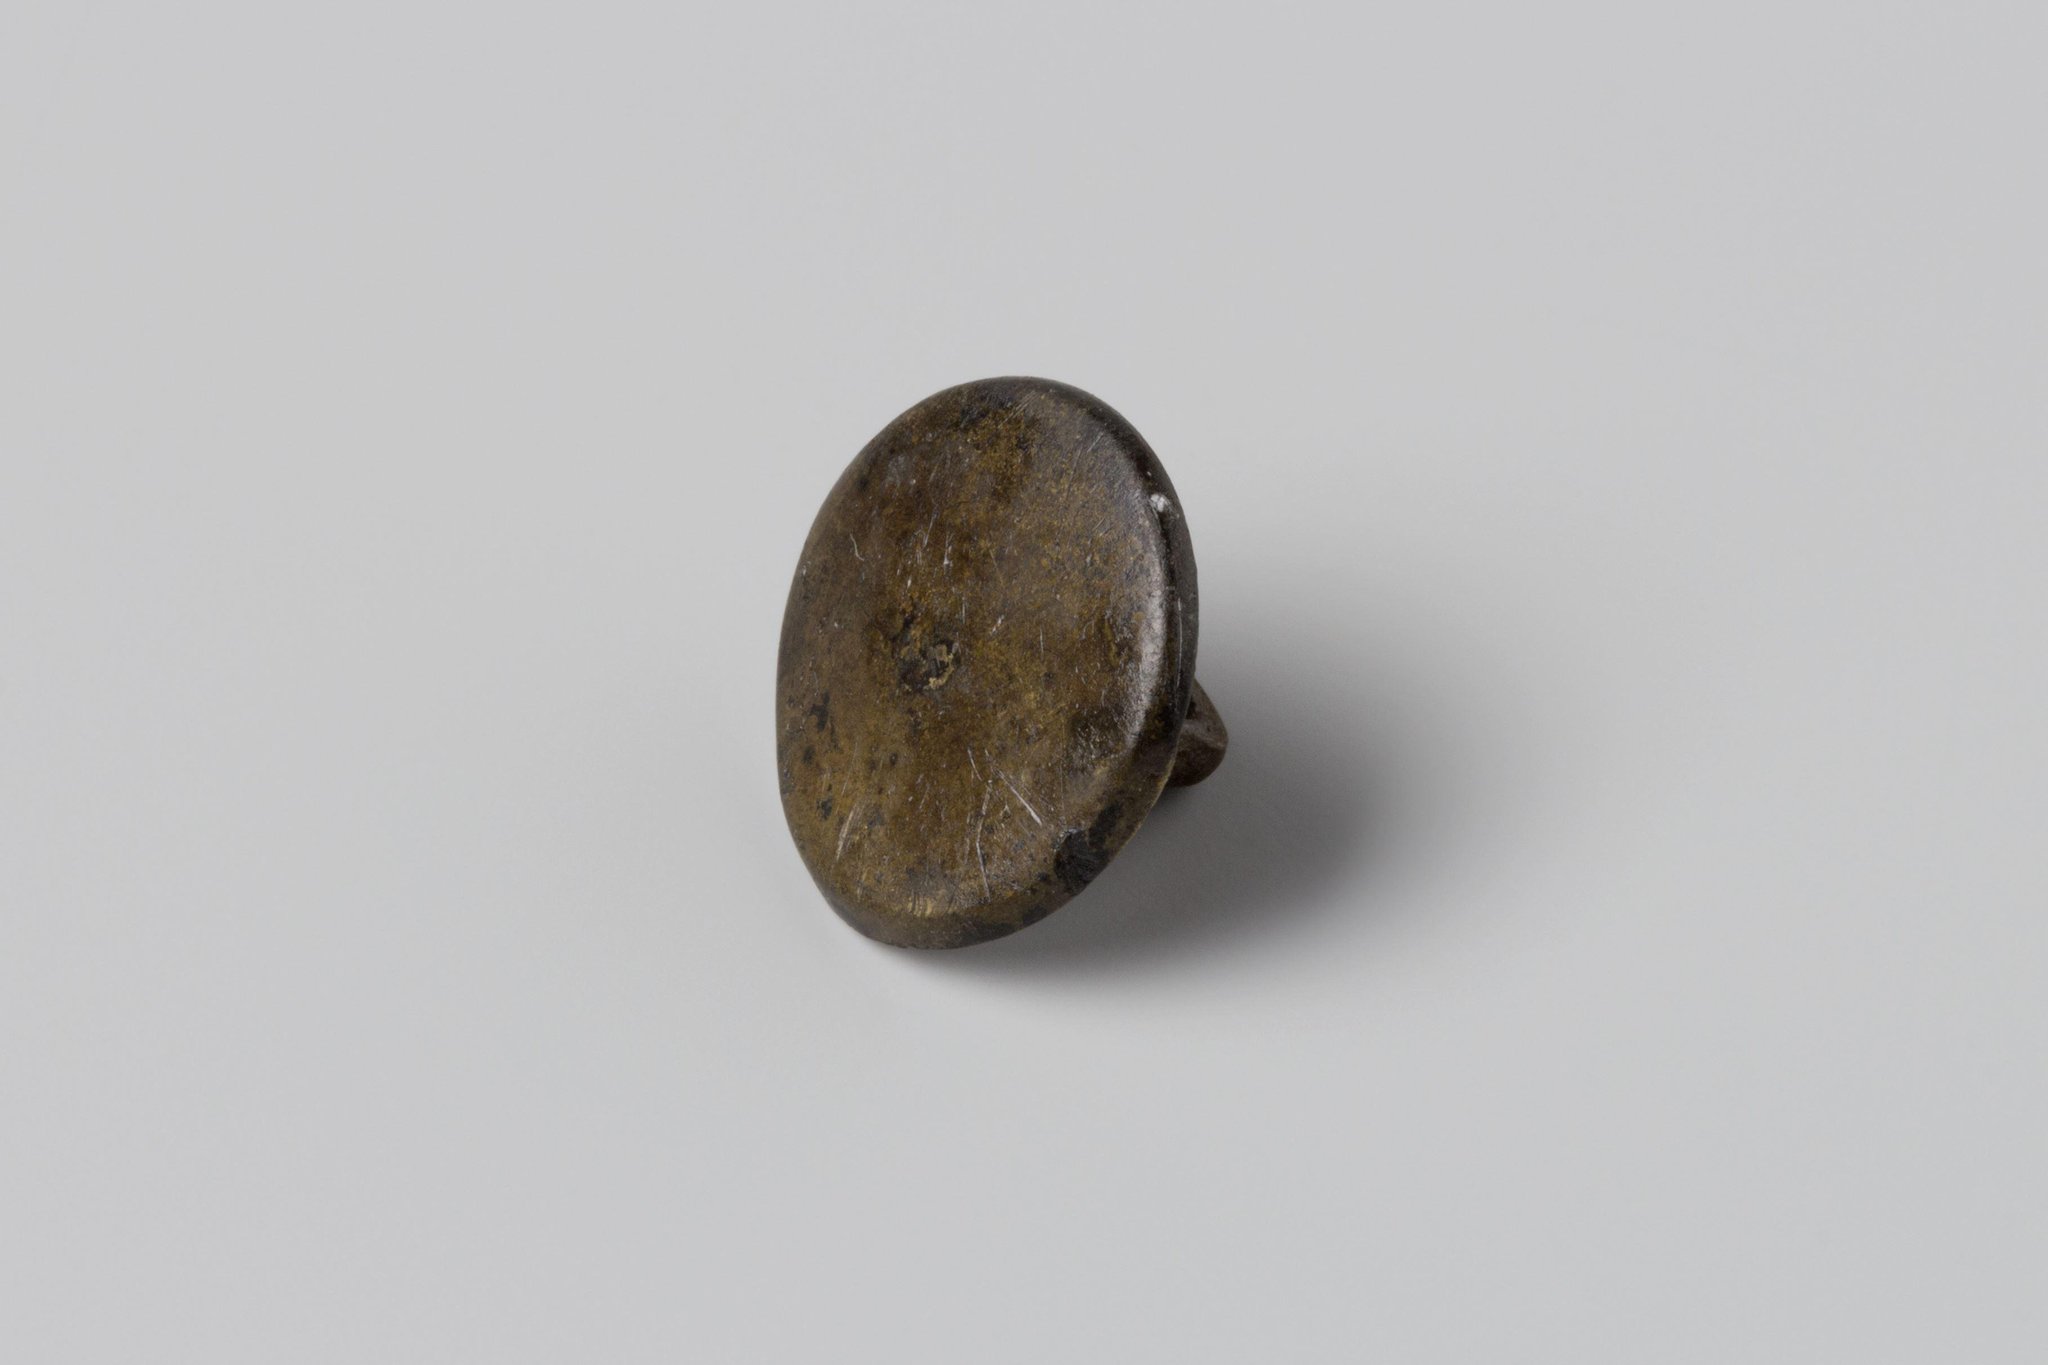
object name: button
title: Knoop uit het wrak van de Oost-Indiëvaarder Hollandia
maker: Anonymous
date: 1700-1743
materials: copper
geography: netherlands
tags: verenigde oostindische compagnie, hollandia (schip), annet